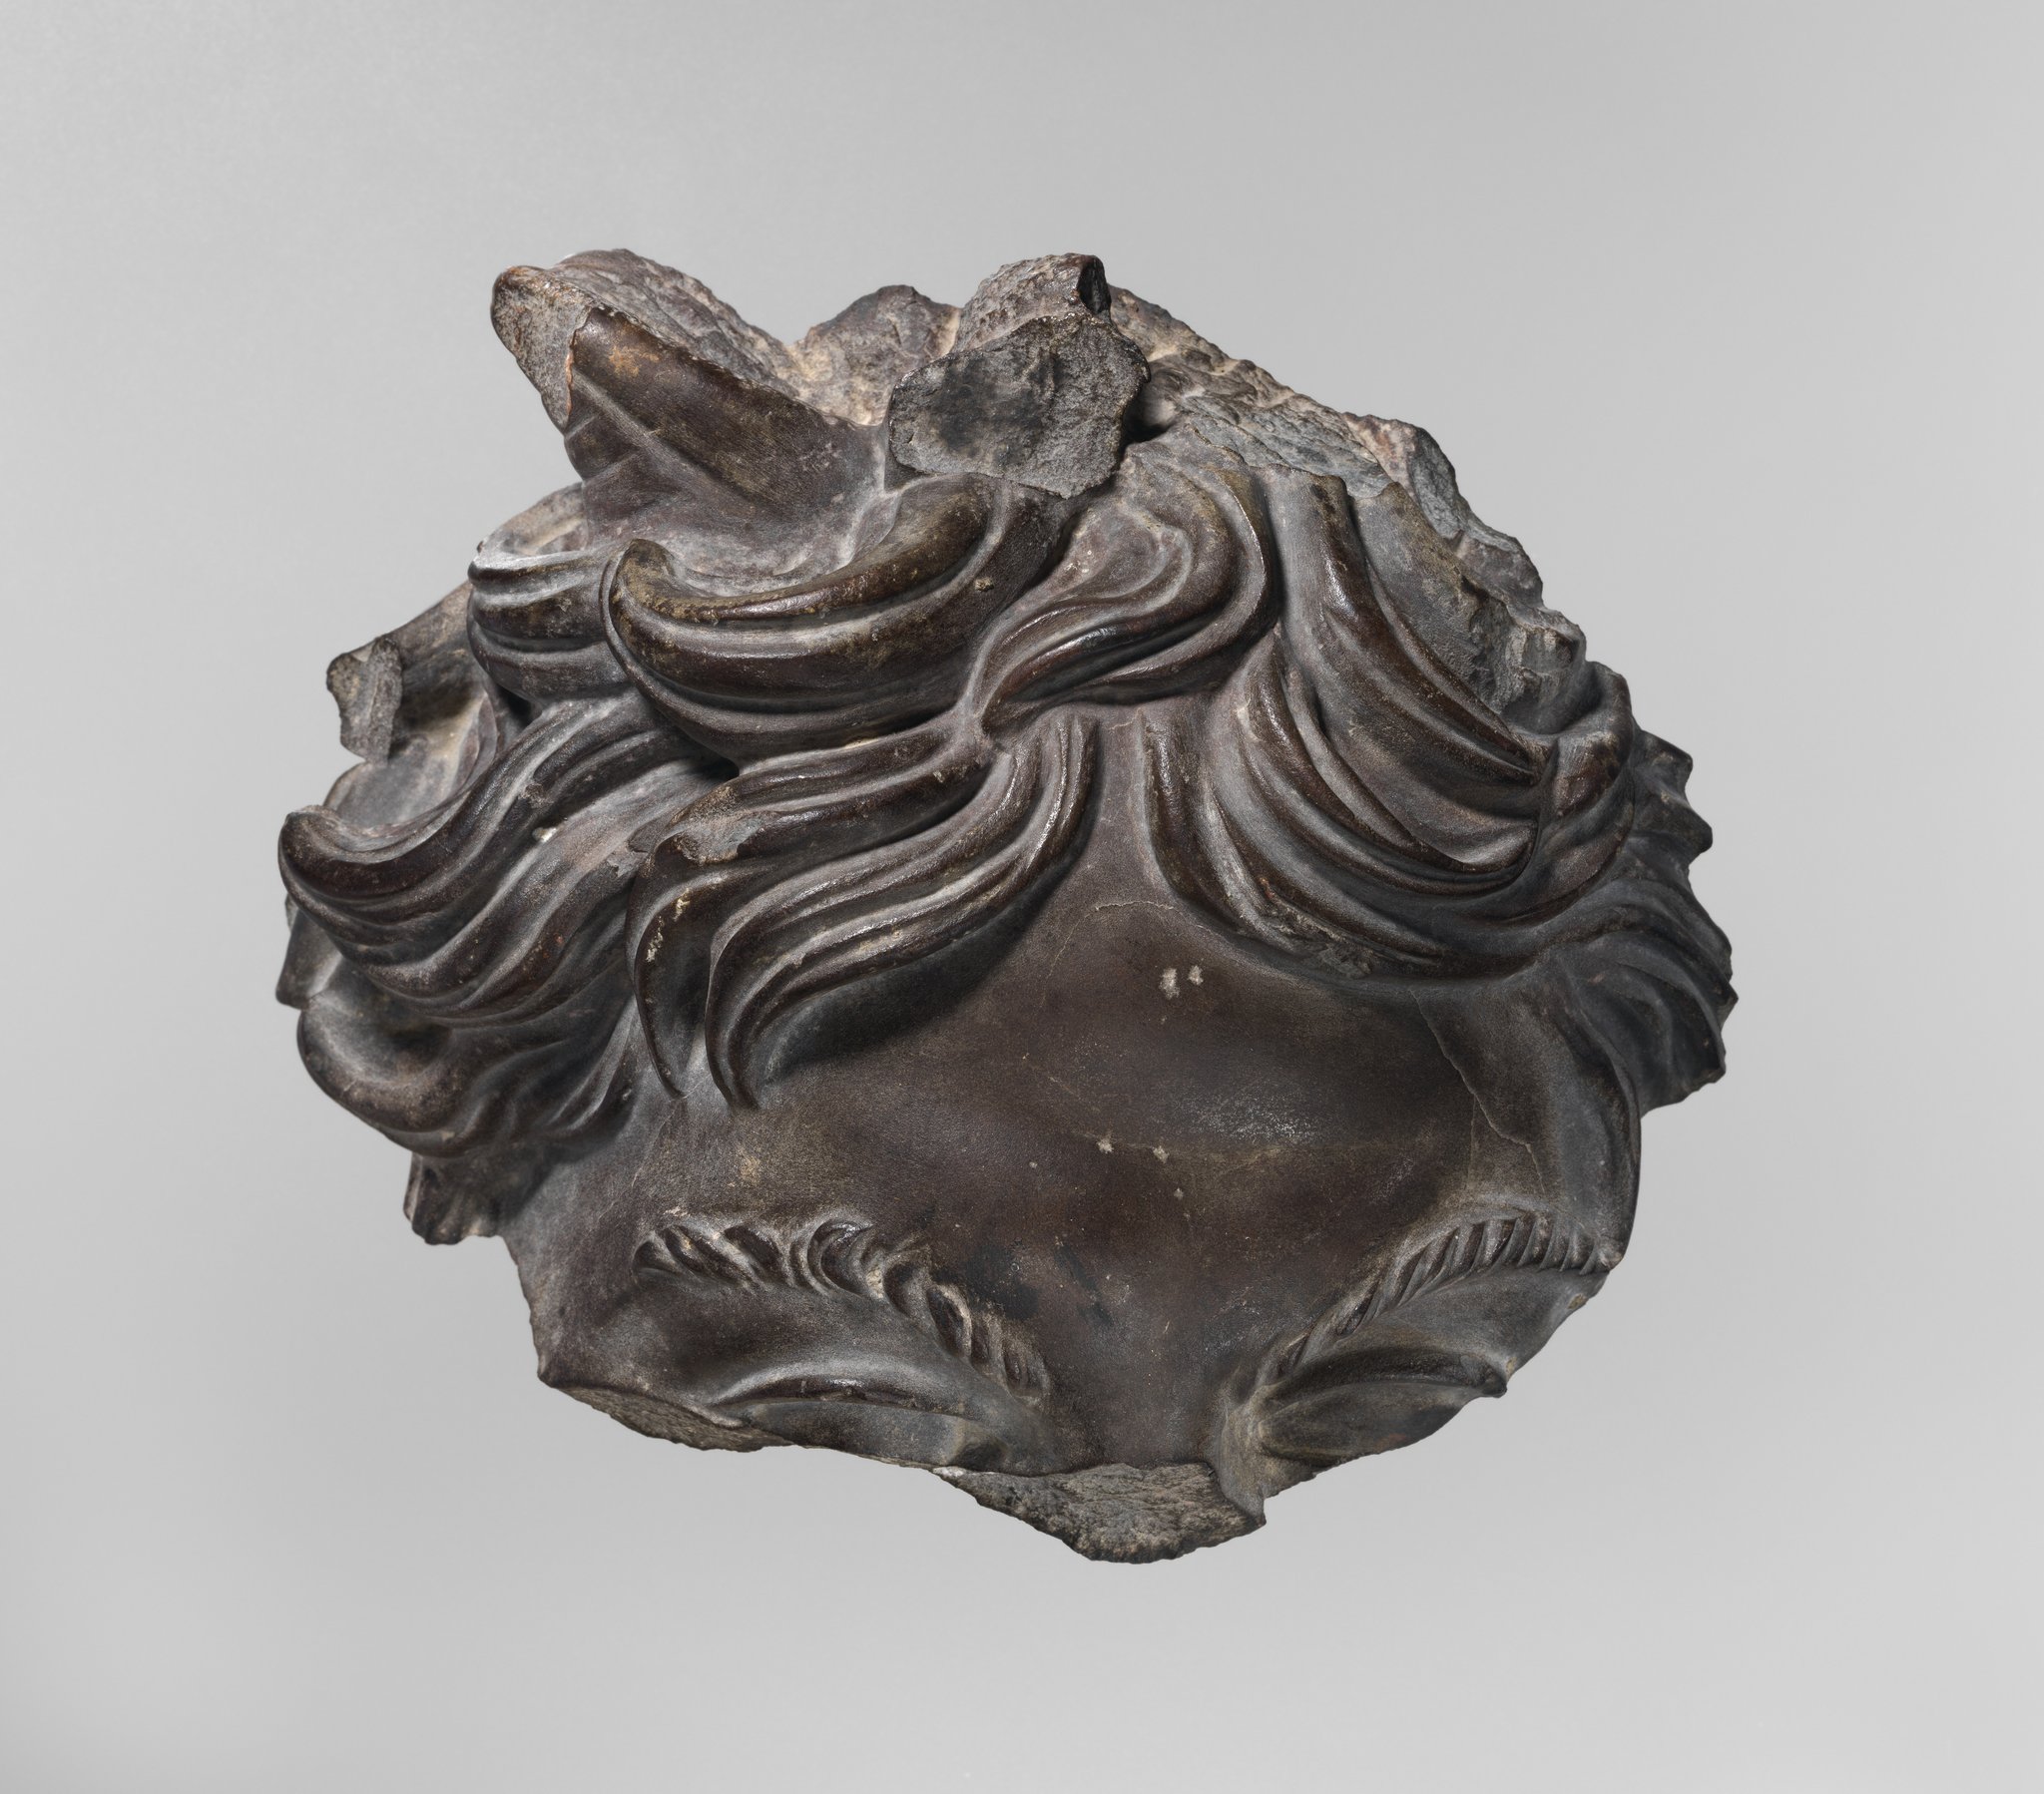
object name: head of a satyr, upper part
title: Greywacke head of a satyr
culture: roman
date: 1-100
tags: heads,satyrs